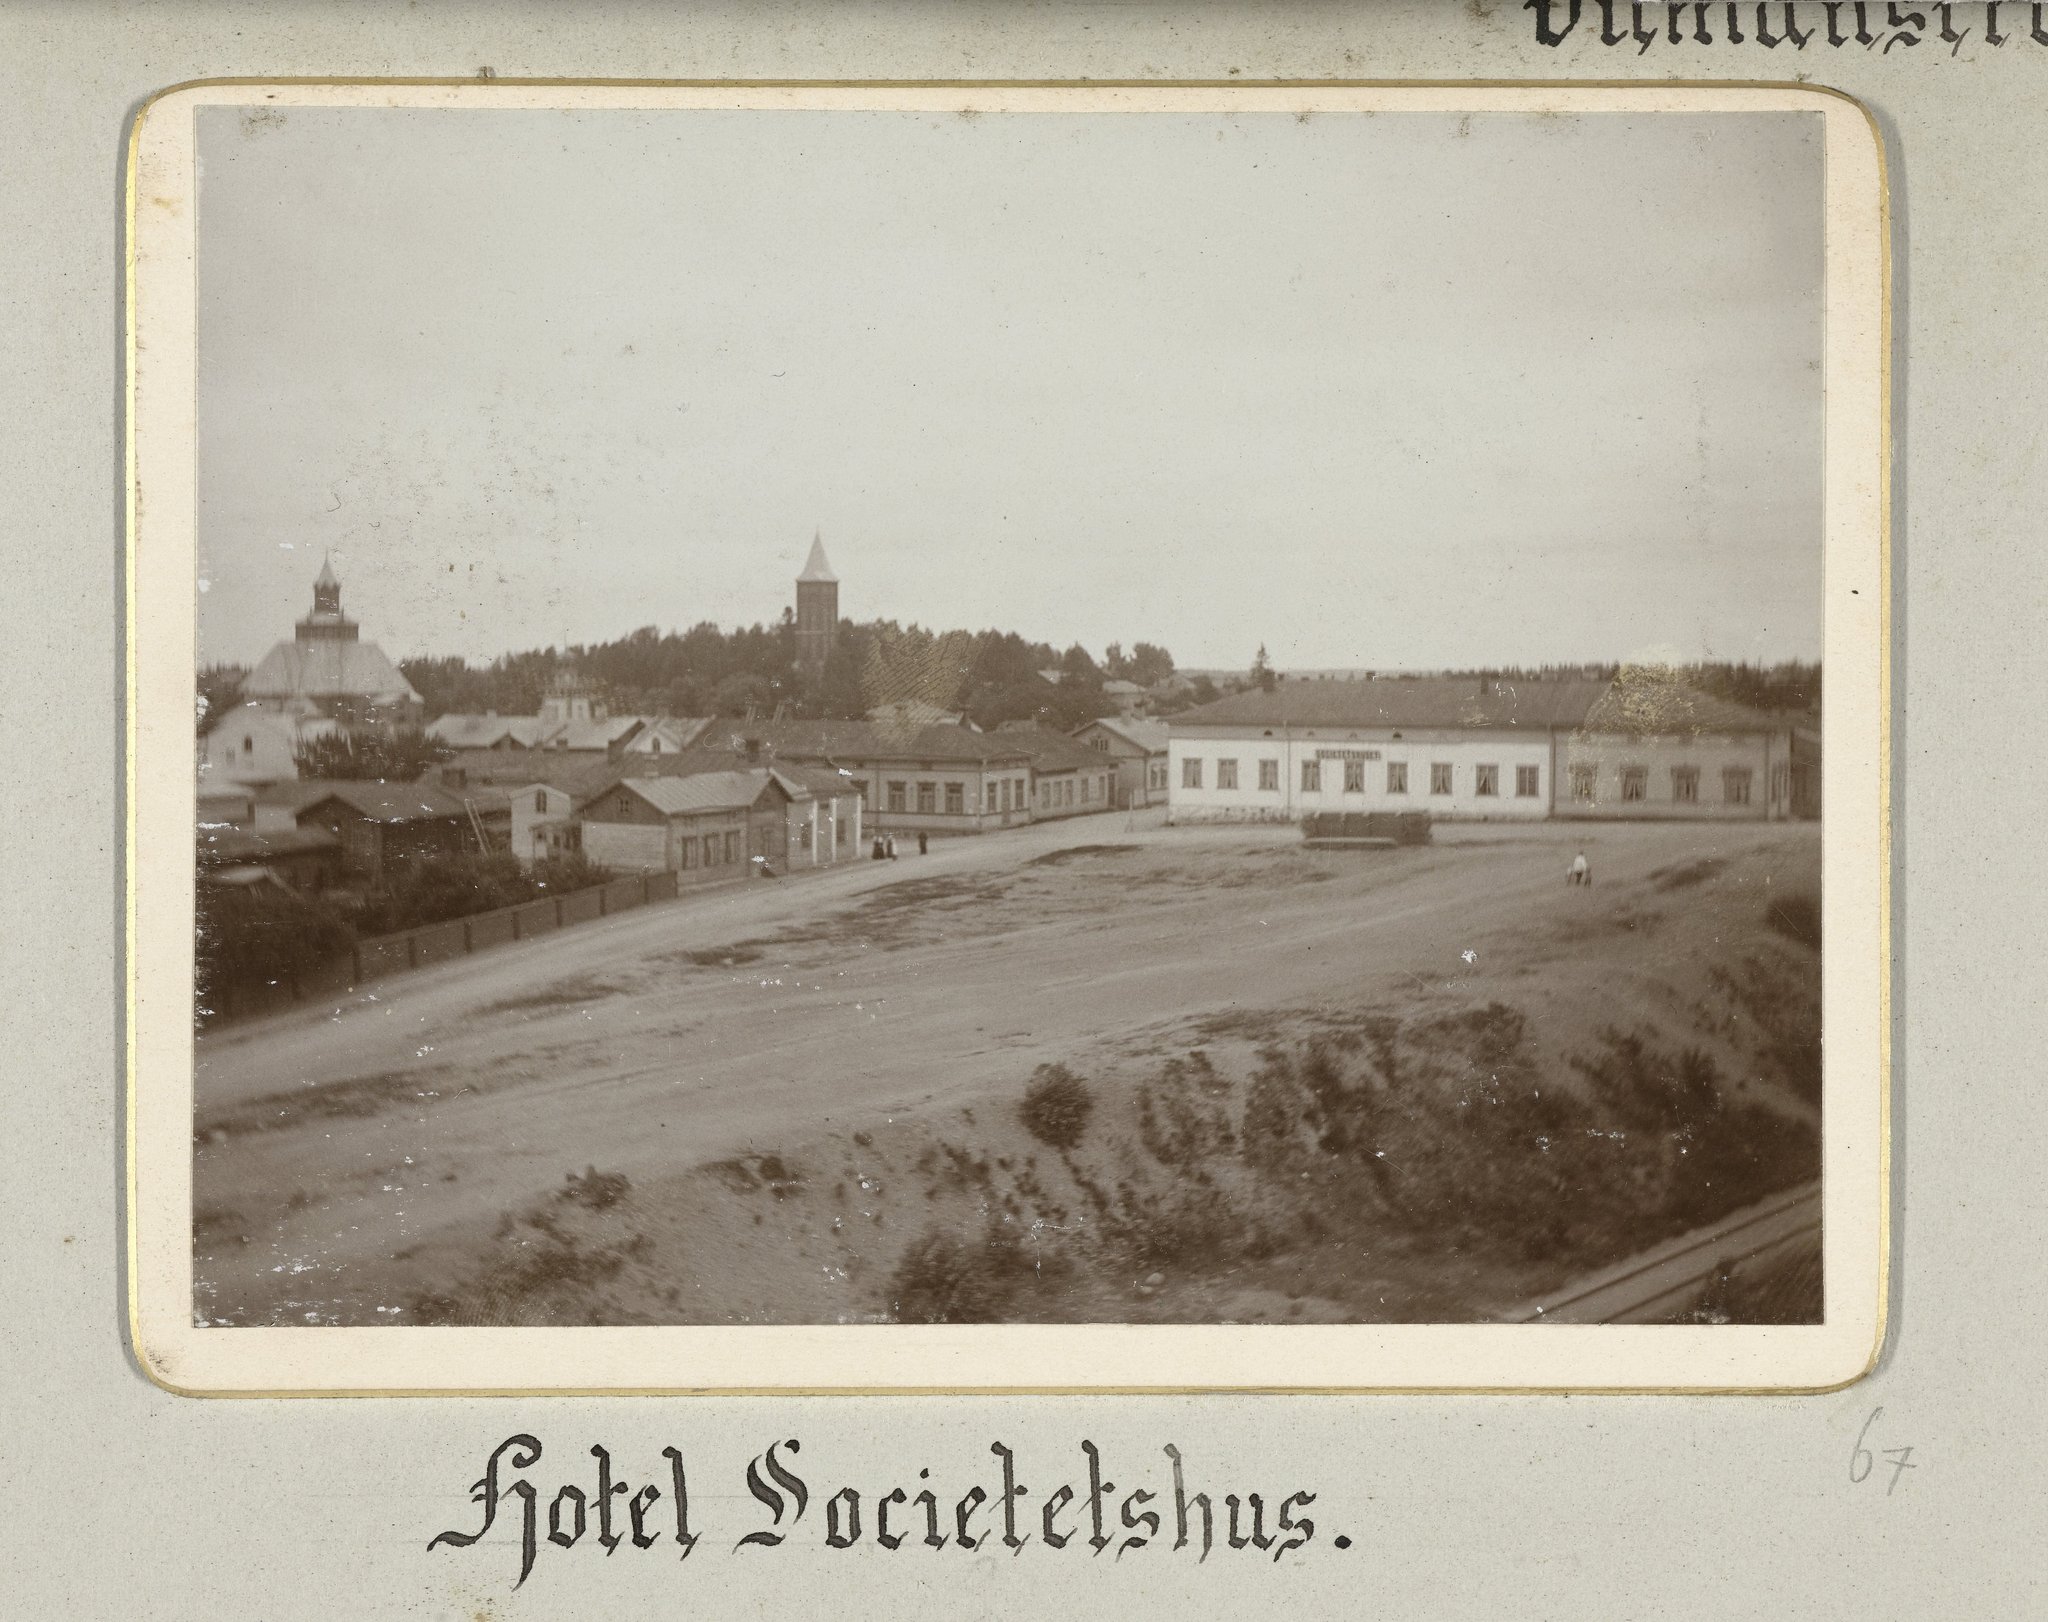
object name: photograph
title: Lappeenranta in Finland gezien van een hoger gelegen gedeelte.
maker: henry pauw van wieldrecht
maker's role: fotograaf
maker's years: 1863-1912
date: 1898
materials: paper, photographic support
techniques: albumen print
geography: netherlands